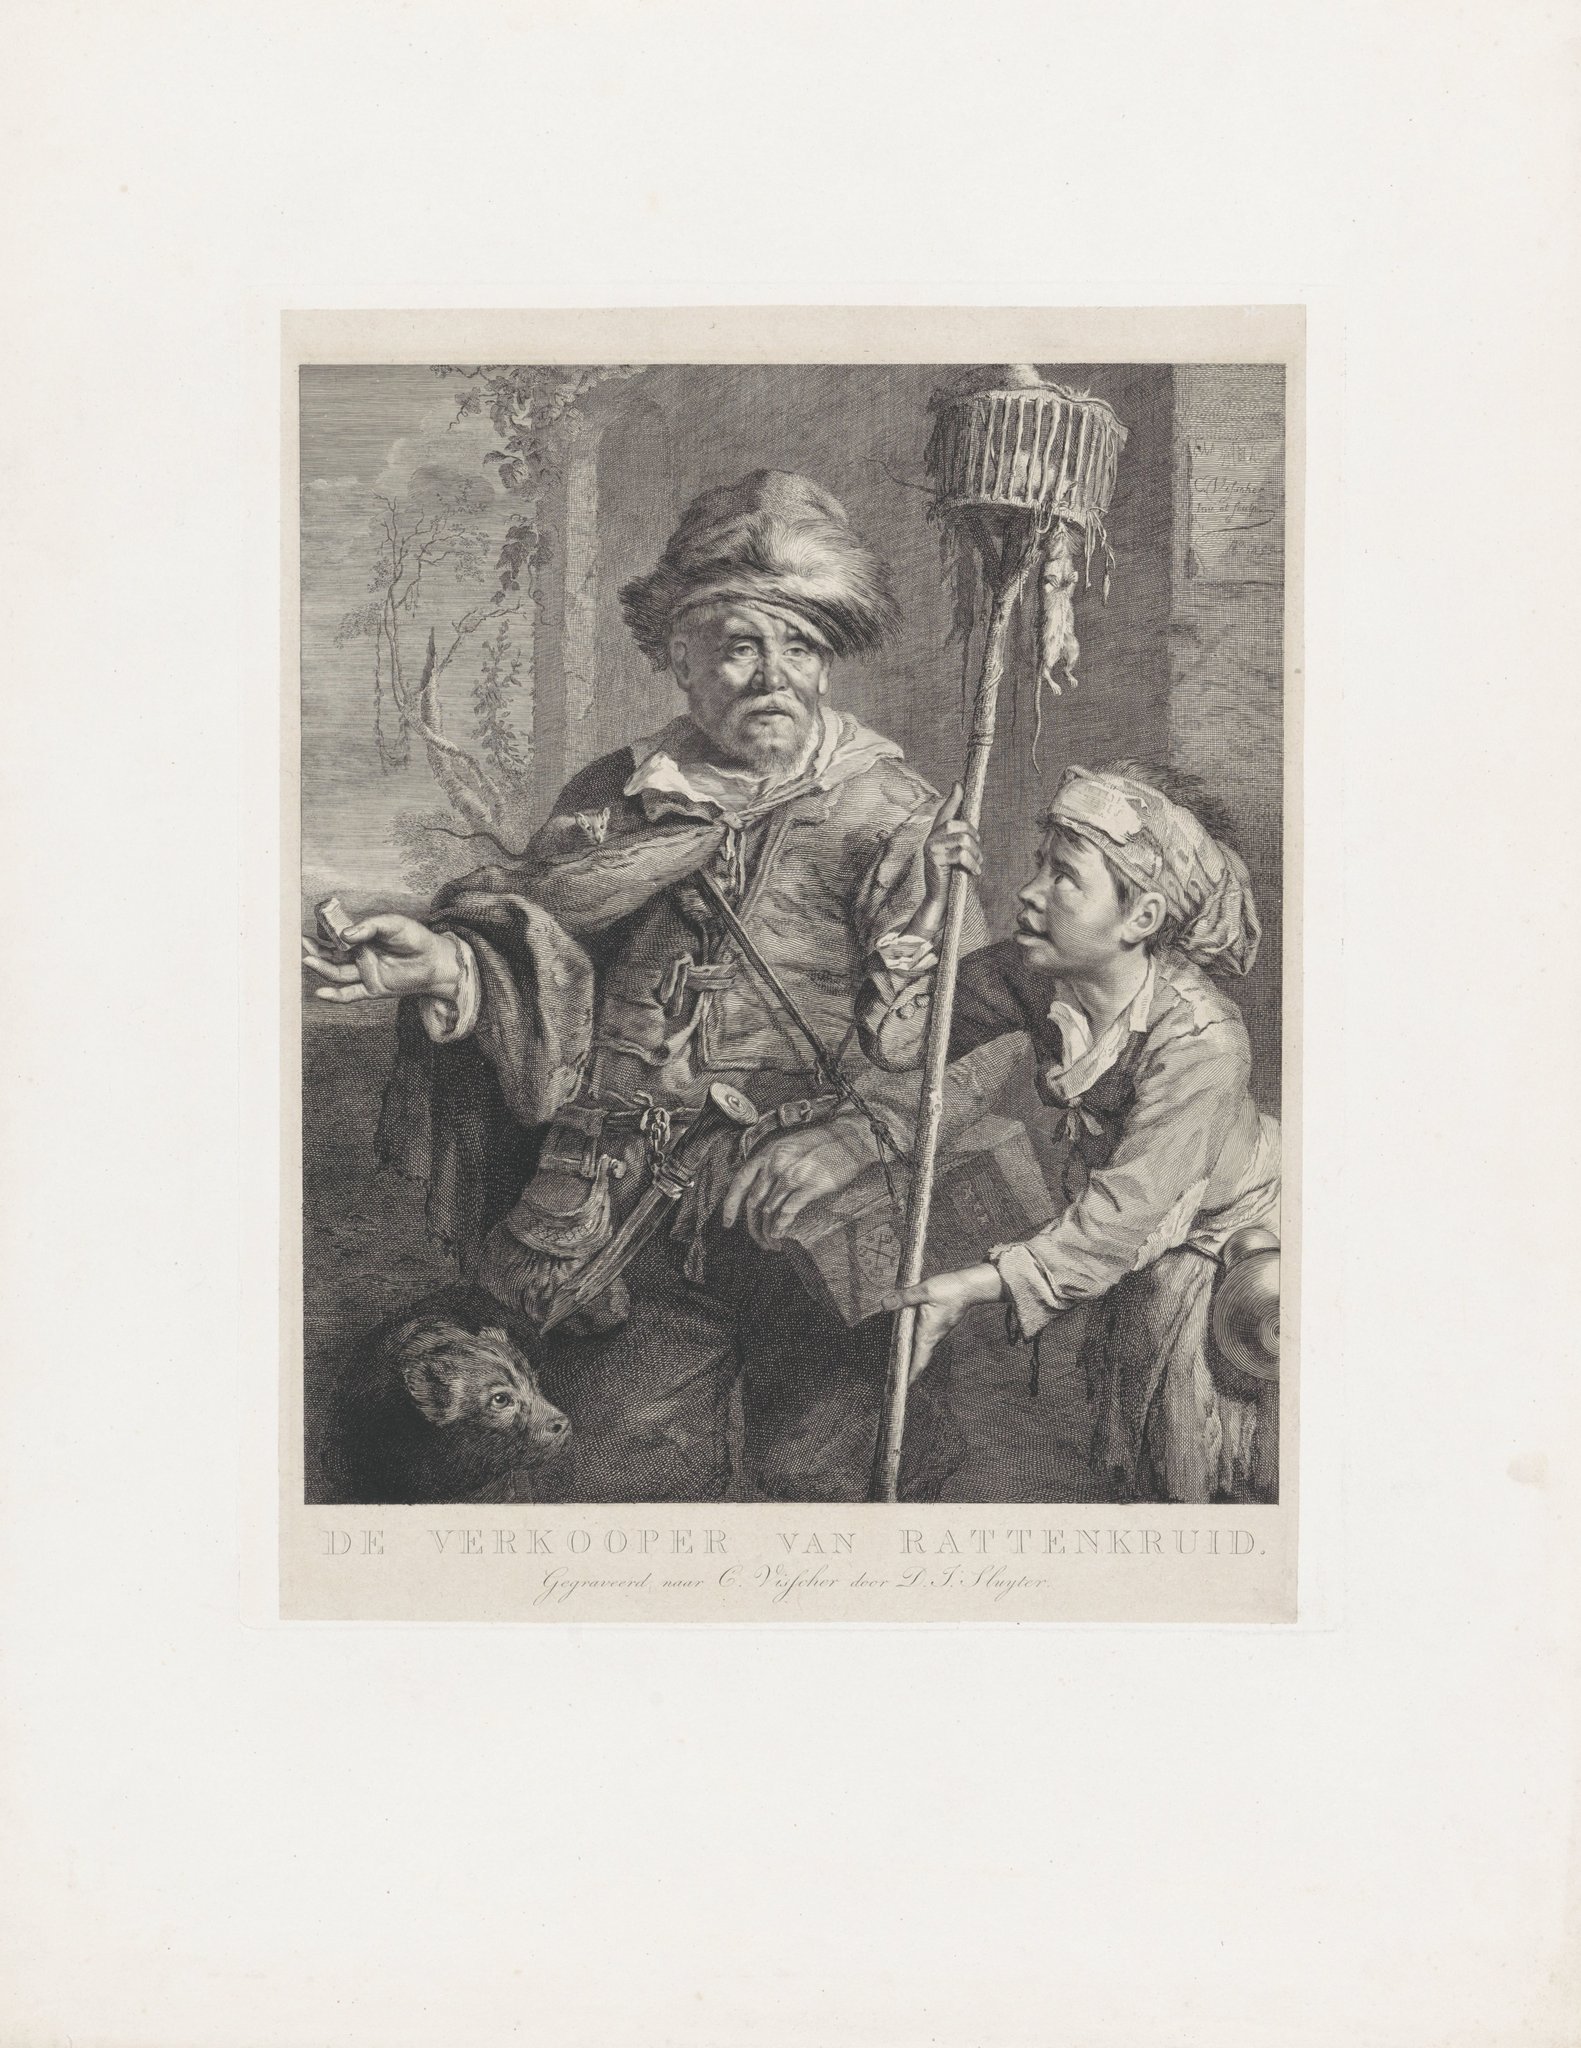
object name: print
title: De verkooper van rattenkruid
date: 1826-1886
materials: paper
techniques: engraving, etching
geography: amsterdam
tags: rat exterminator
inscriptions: collector's mark: Lugt 2228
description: Een rattenvanger met zijn hond en knecht. De jongen houdt een staf met een rattenkooi vast. De rattenvanger draagt een tas en gereedschap met zich mee, op zijn mantel loopt een rat. Op een kist die hij op zijn heup draagt staan de wapens van Leiden en Amsterdam.